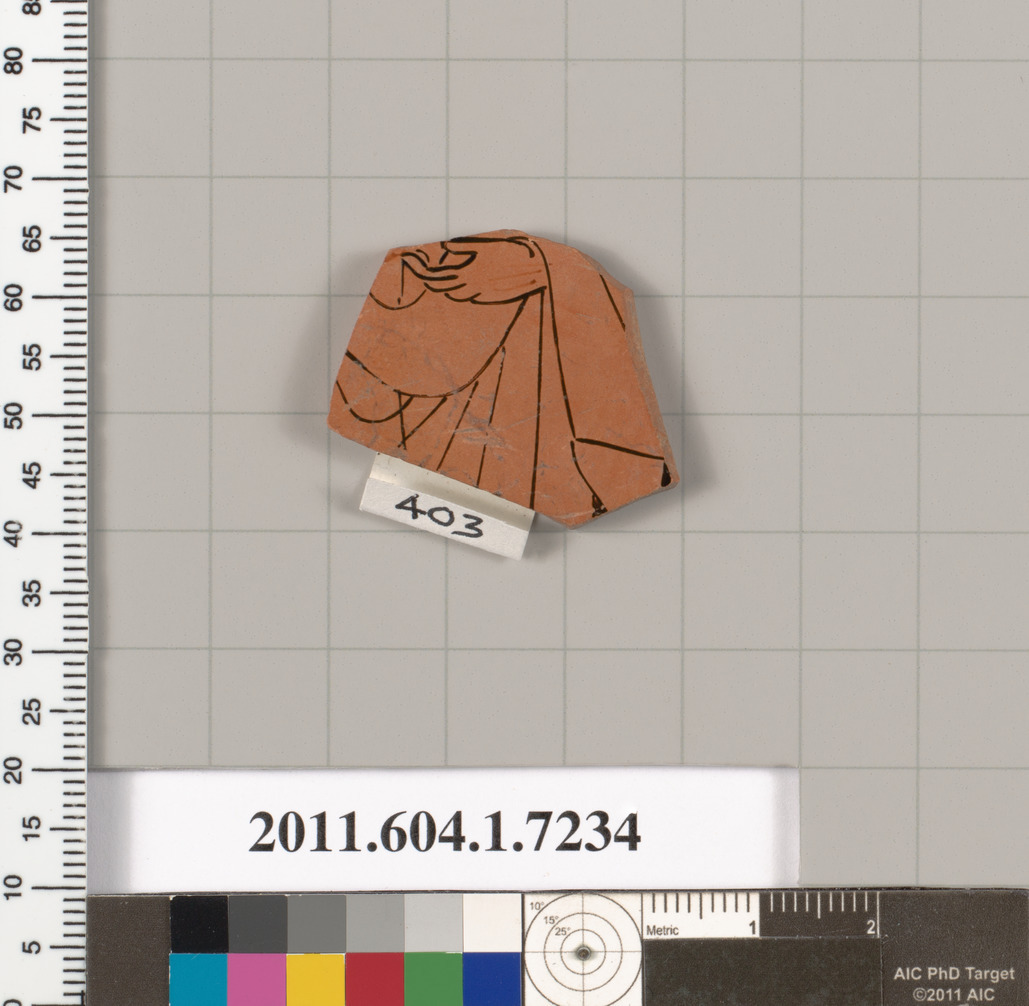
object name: kylix fragment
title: Terracotta fragment of a kylix (drinking cup)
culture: greek, attic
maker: makron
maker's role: artist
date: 500-480 BCE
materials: terracotta